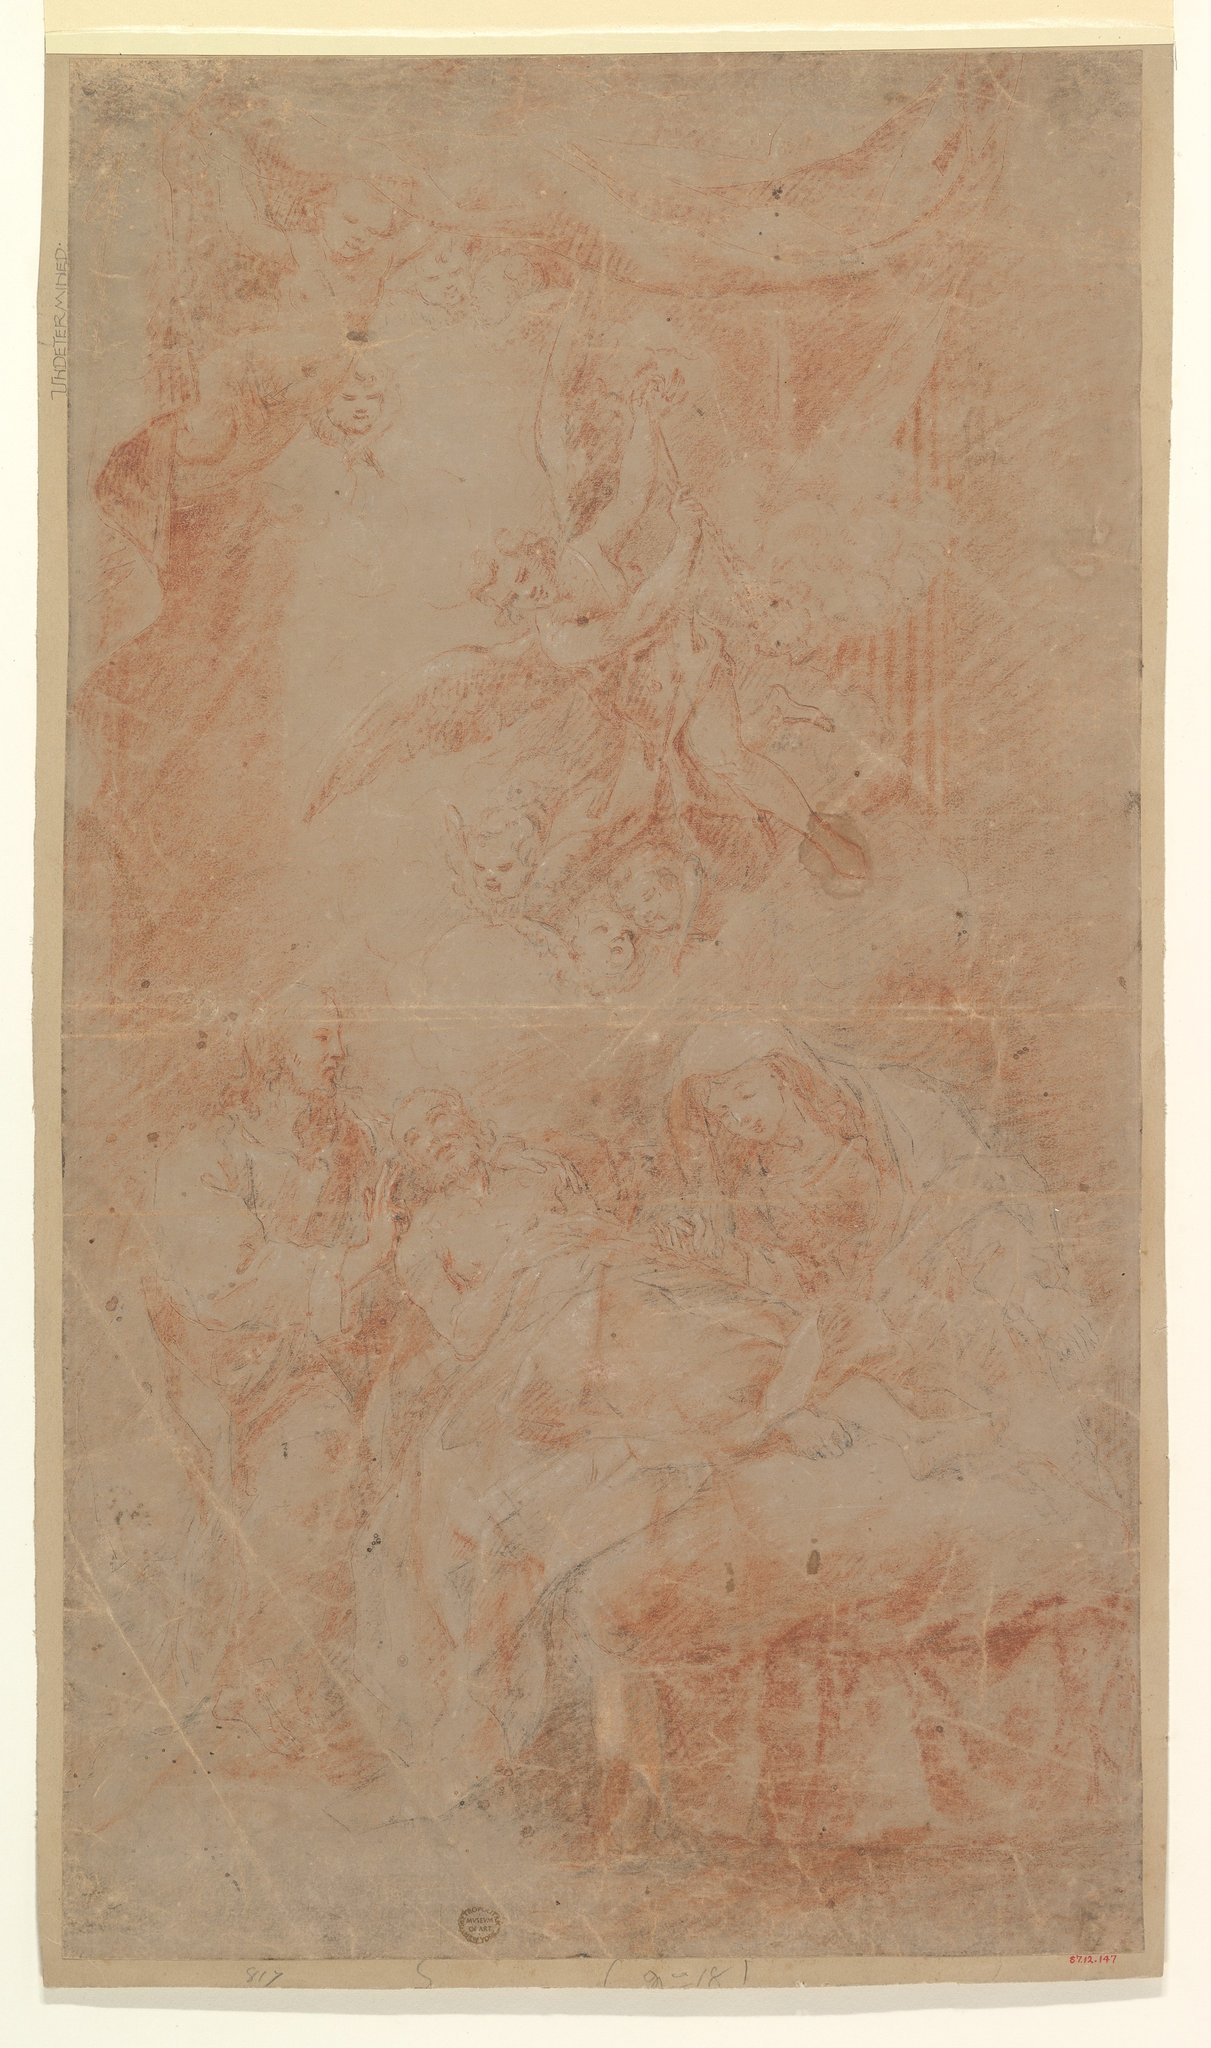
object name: drawing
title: Death of Saint Joseph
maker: anonymous, italian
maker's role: artist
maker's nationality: italian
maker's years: 1400-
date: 1550-1750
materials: chalk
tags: sadness,men,women,angels,saint joseph,saints,death